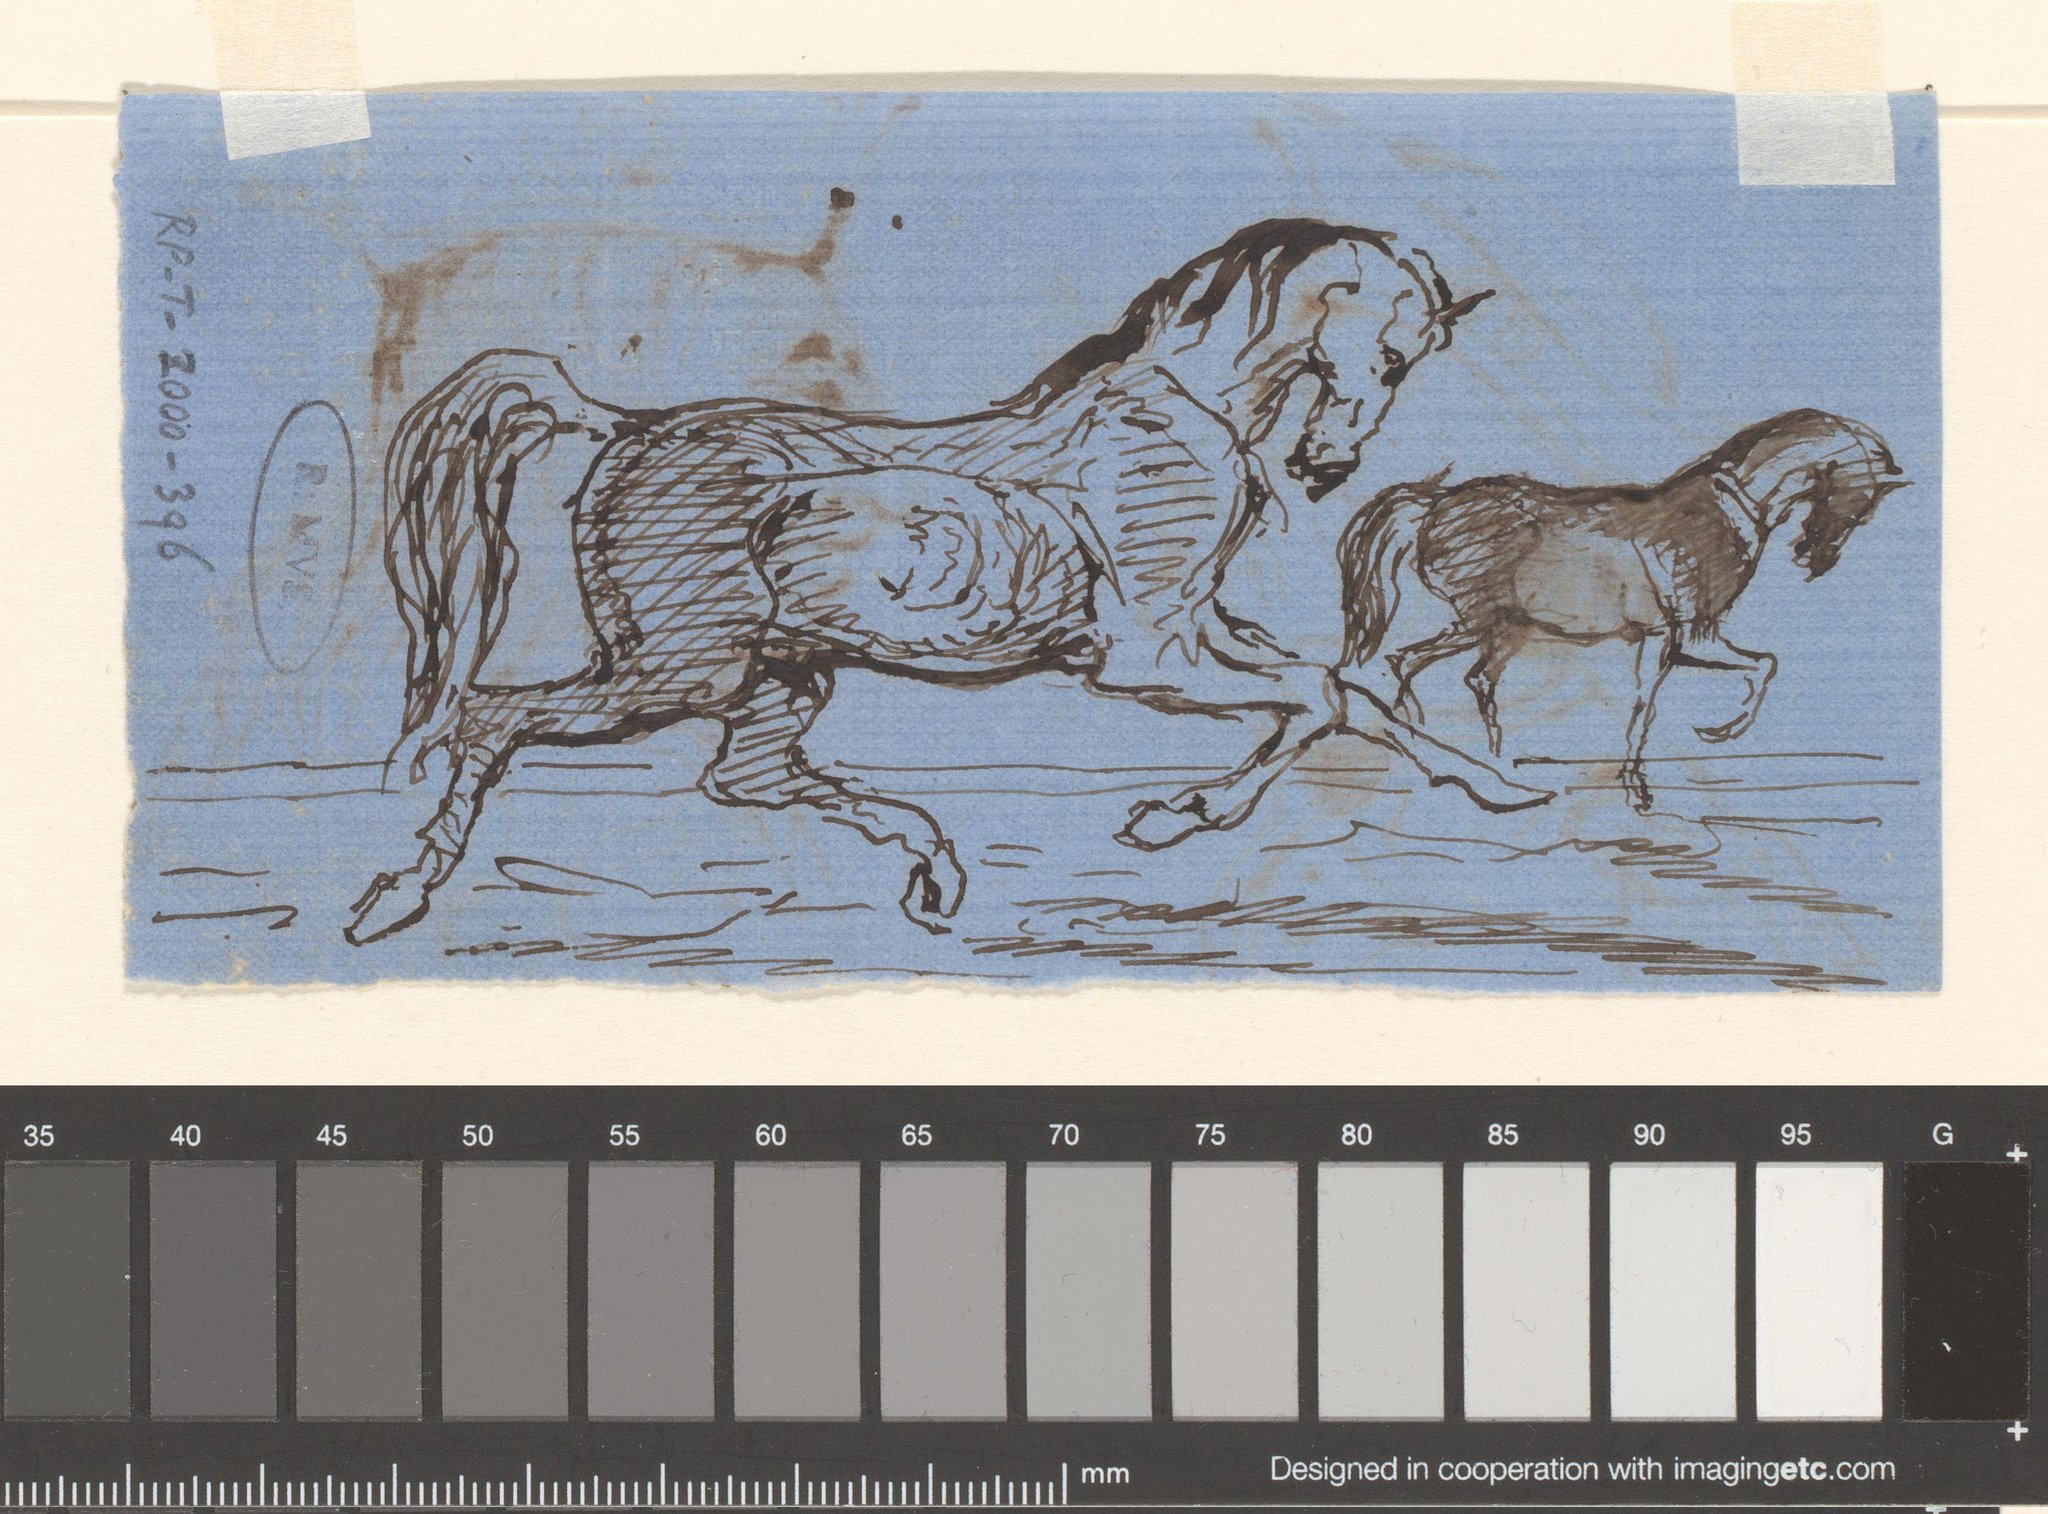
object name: drawing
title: Twee studies van een paard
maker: johannes tavenraat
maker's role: draughtsman, painter, print maker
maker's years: 1809-1881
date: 1840-1880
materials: ink, paper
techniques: brush, pen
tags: horse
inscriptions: collector's mark: Lugt 2228